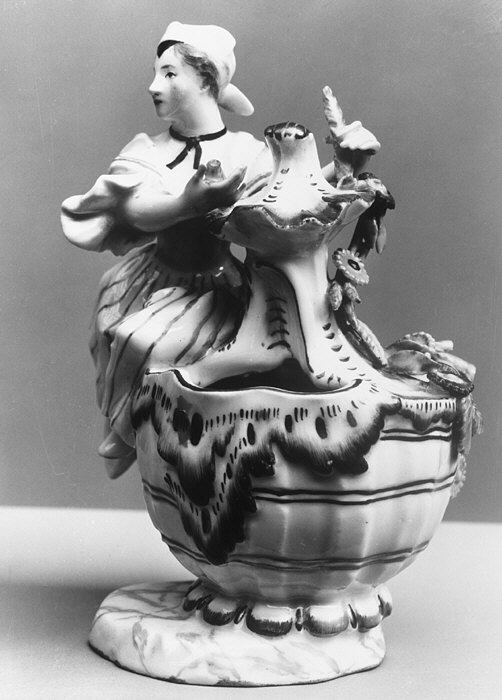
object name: jar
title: Condiment jar (one of a pair), with figure symbolizing Summer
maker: höchst manufactory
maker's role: manufactory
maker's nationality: german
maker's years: 1746-1796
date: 1750-1755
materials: hard paste porcelain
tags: women